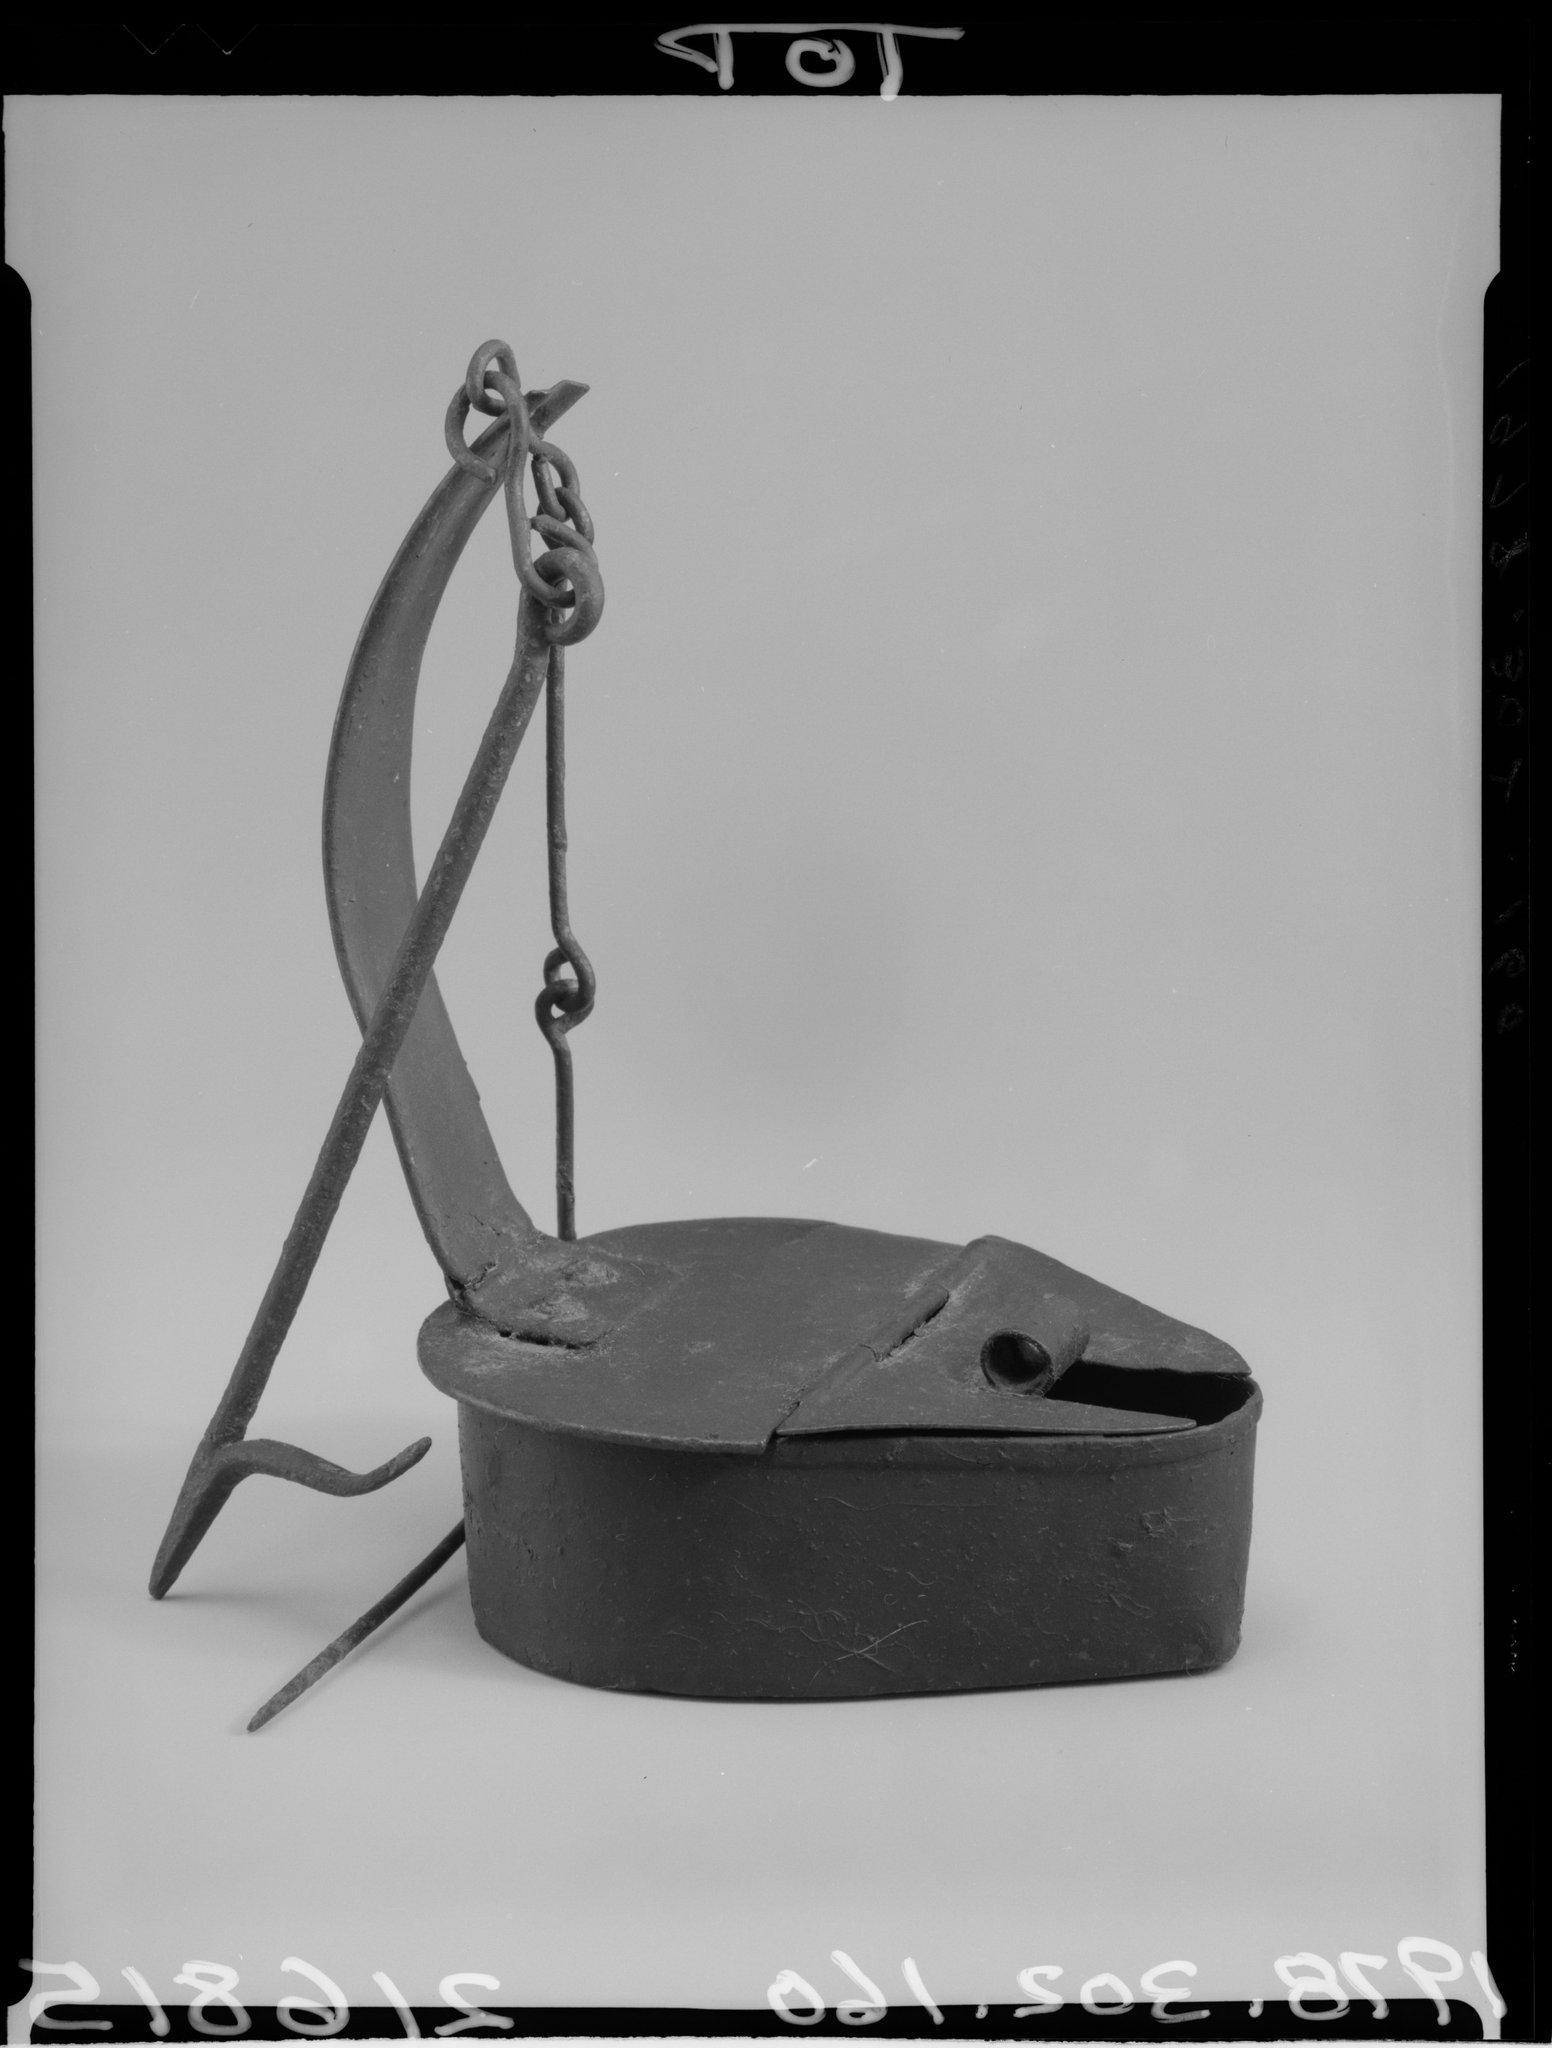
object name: betty lamp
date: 1700-1800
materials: iron